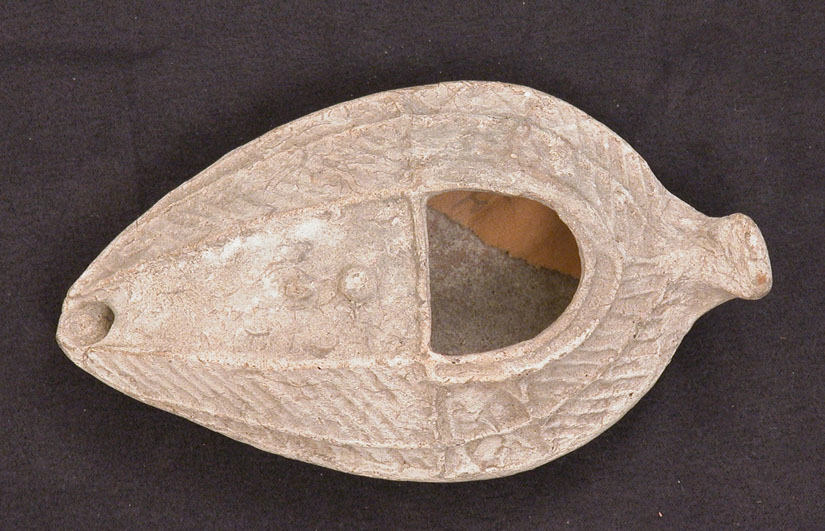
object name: lamp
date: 601-800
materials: earthenware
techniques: molding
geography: palestine